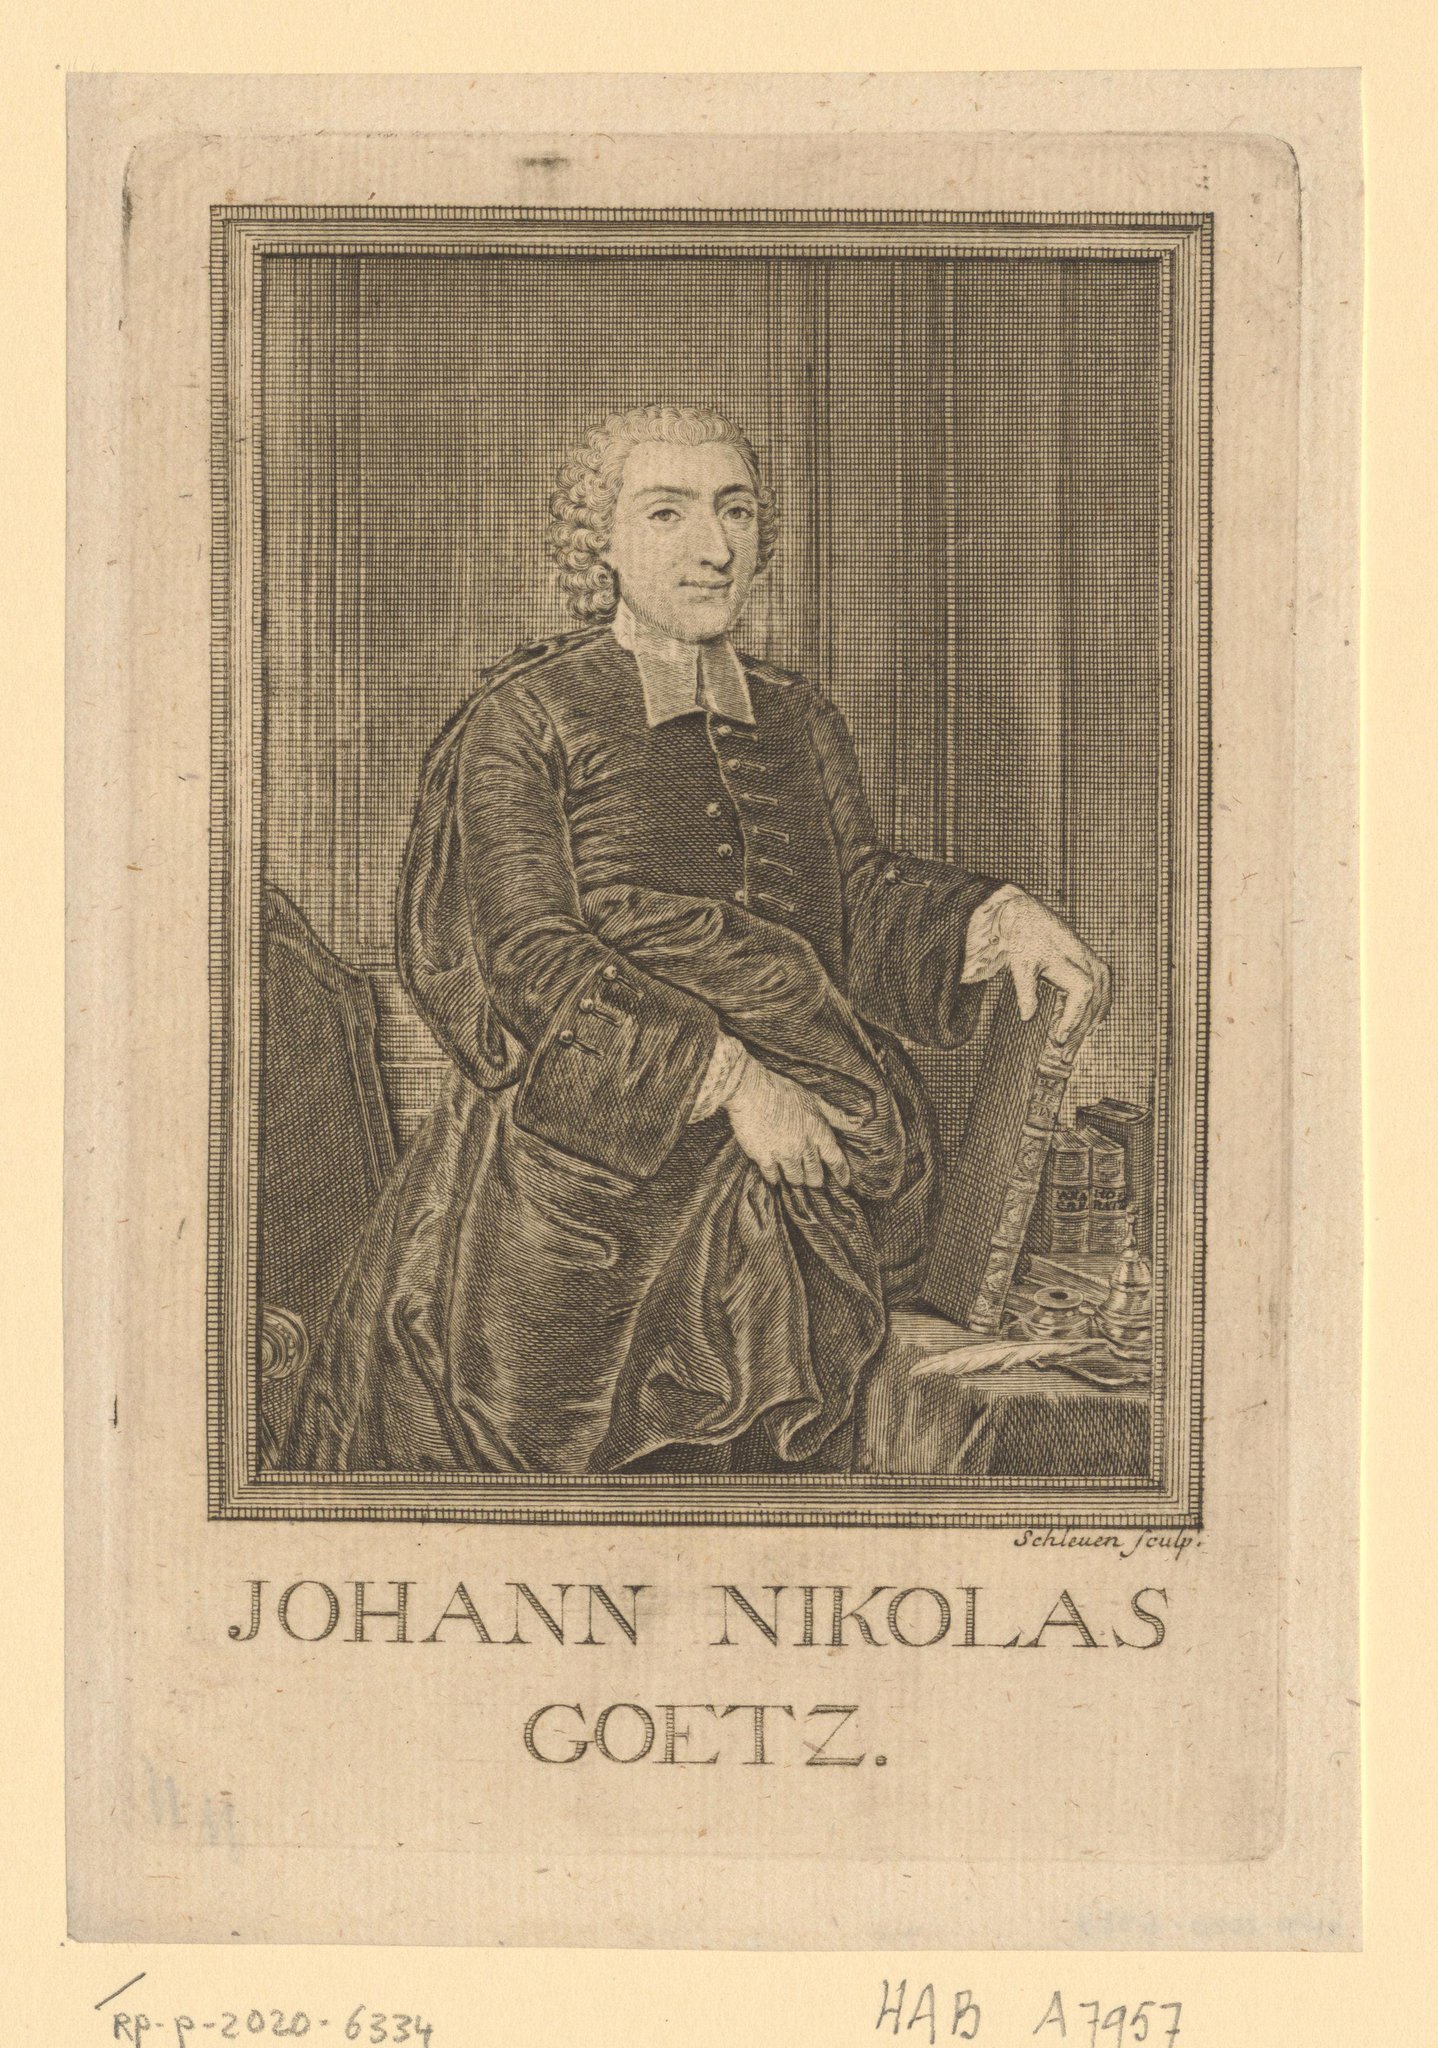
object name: print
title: Portret van Johann Nikolaus Götz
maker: johann david schleuen (i)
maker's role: print maker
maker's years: 1711-1774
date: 1726-1774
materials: paper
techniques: engraving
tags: theologian, historical persons, writer, poet, author